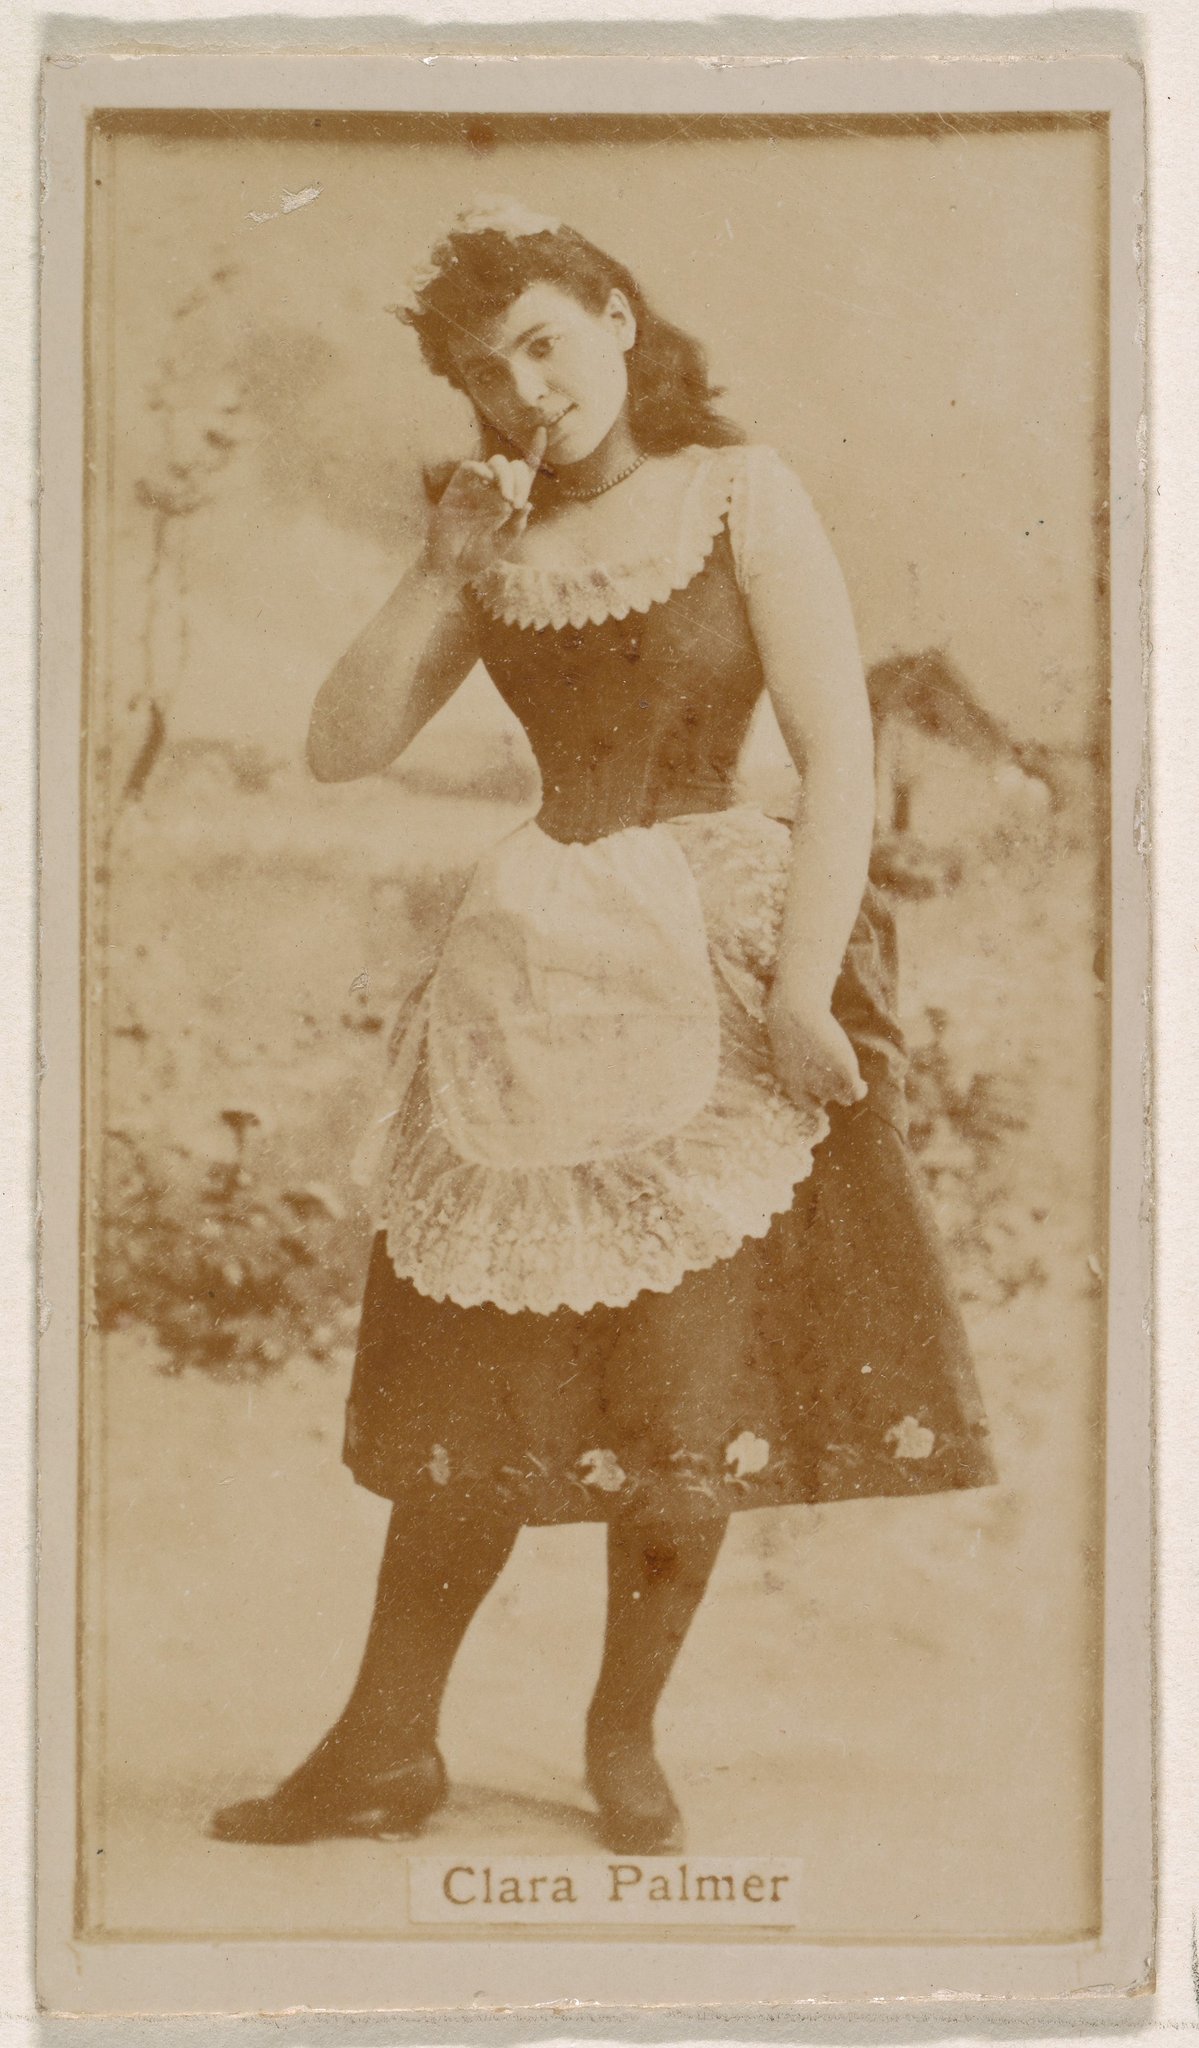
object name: photograph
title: Clara Palmer, from the Actresses series (N245) issued by Kinney Brothers to promote Sweet Caporal Cigarettes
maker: kinney brothers tobacco company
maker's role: publisher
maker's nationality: american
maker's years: 1869-2011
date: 1890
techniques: albumen silver print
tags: portraits,women,actresses